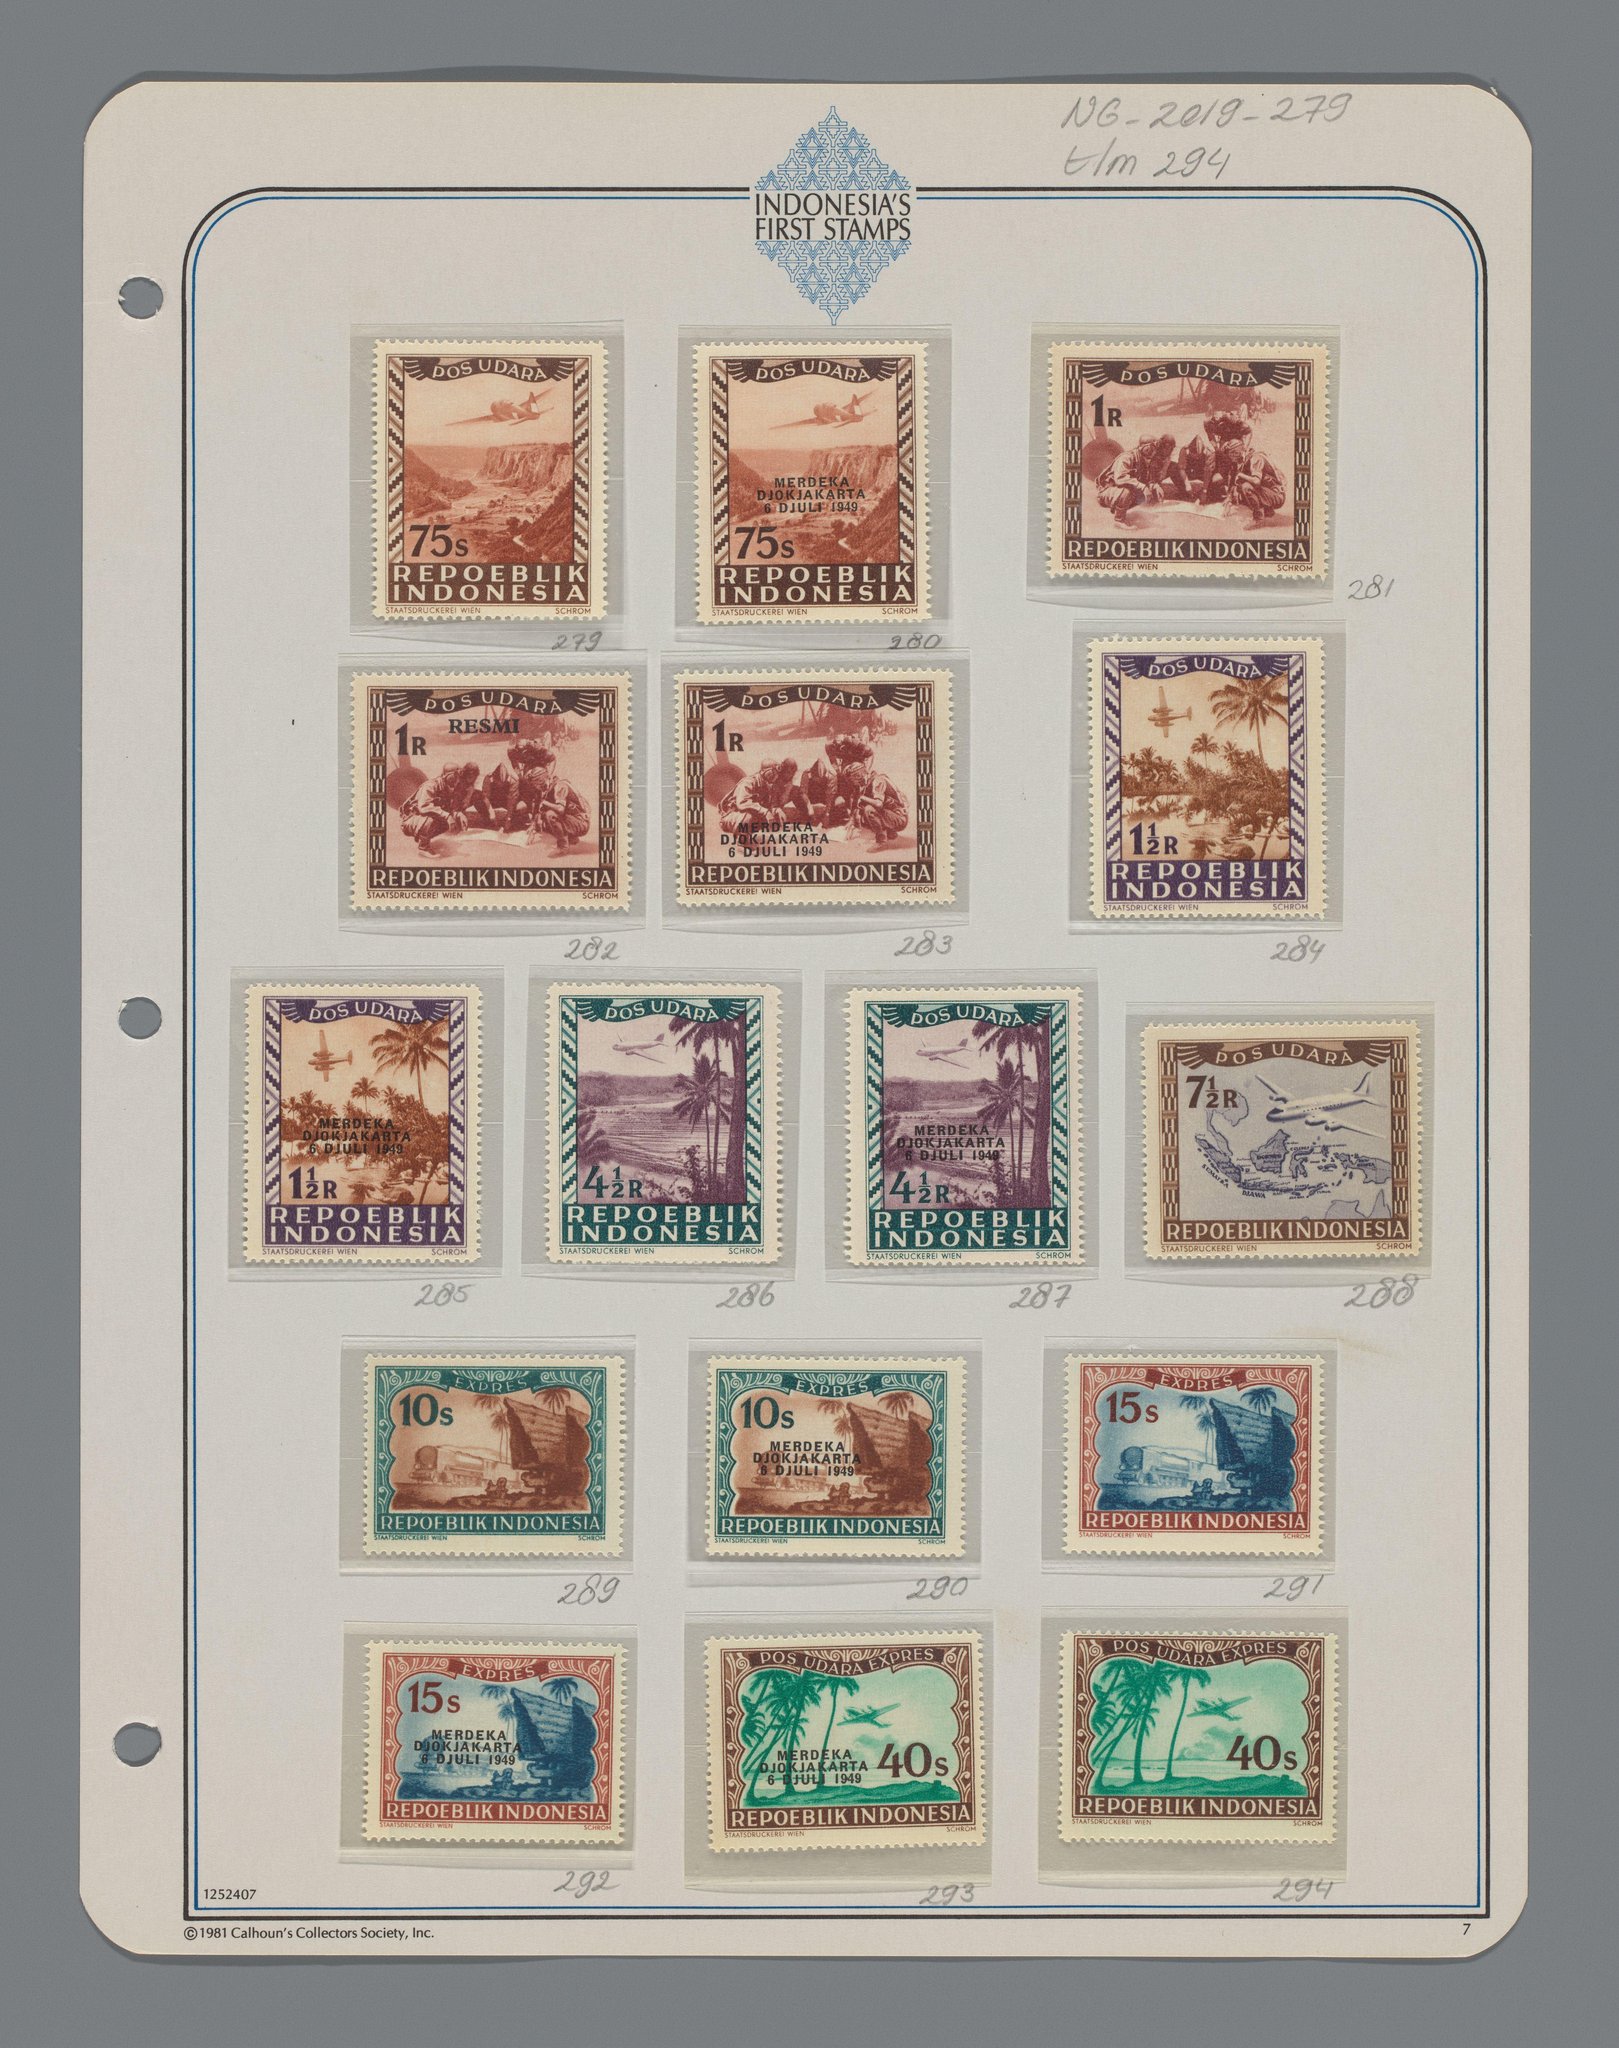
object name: postage stamp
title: Postzegel Republik Indonesia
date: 1949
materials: paper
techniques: photoaquatint, engraving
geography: philadelphia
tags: indonesia